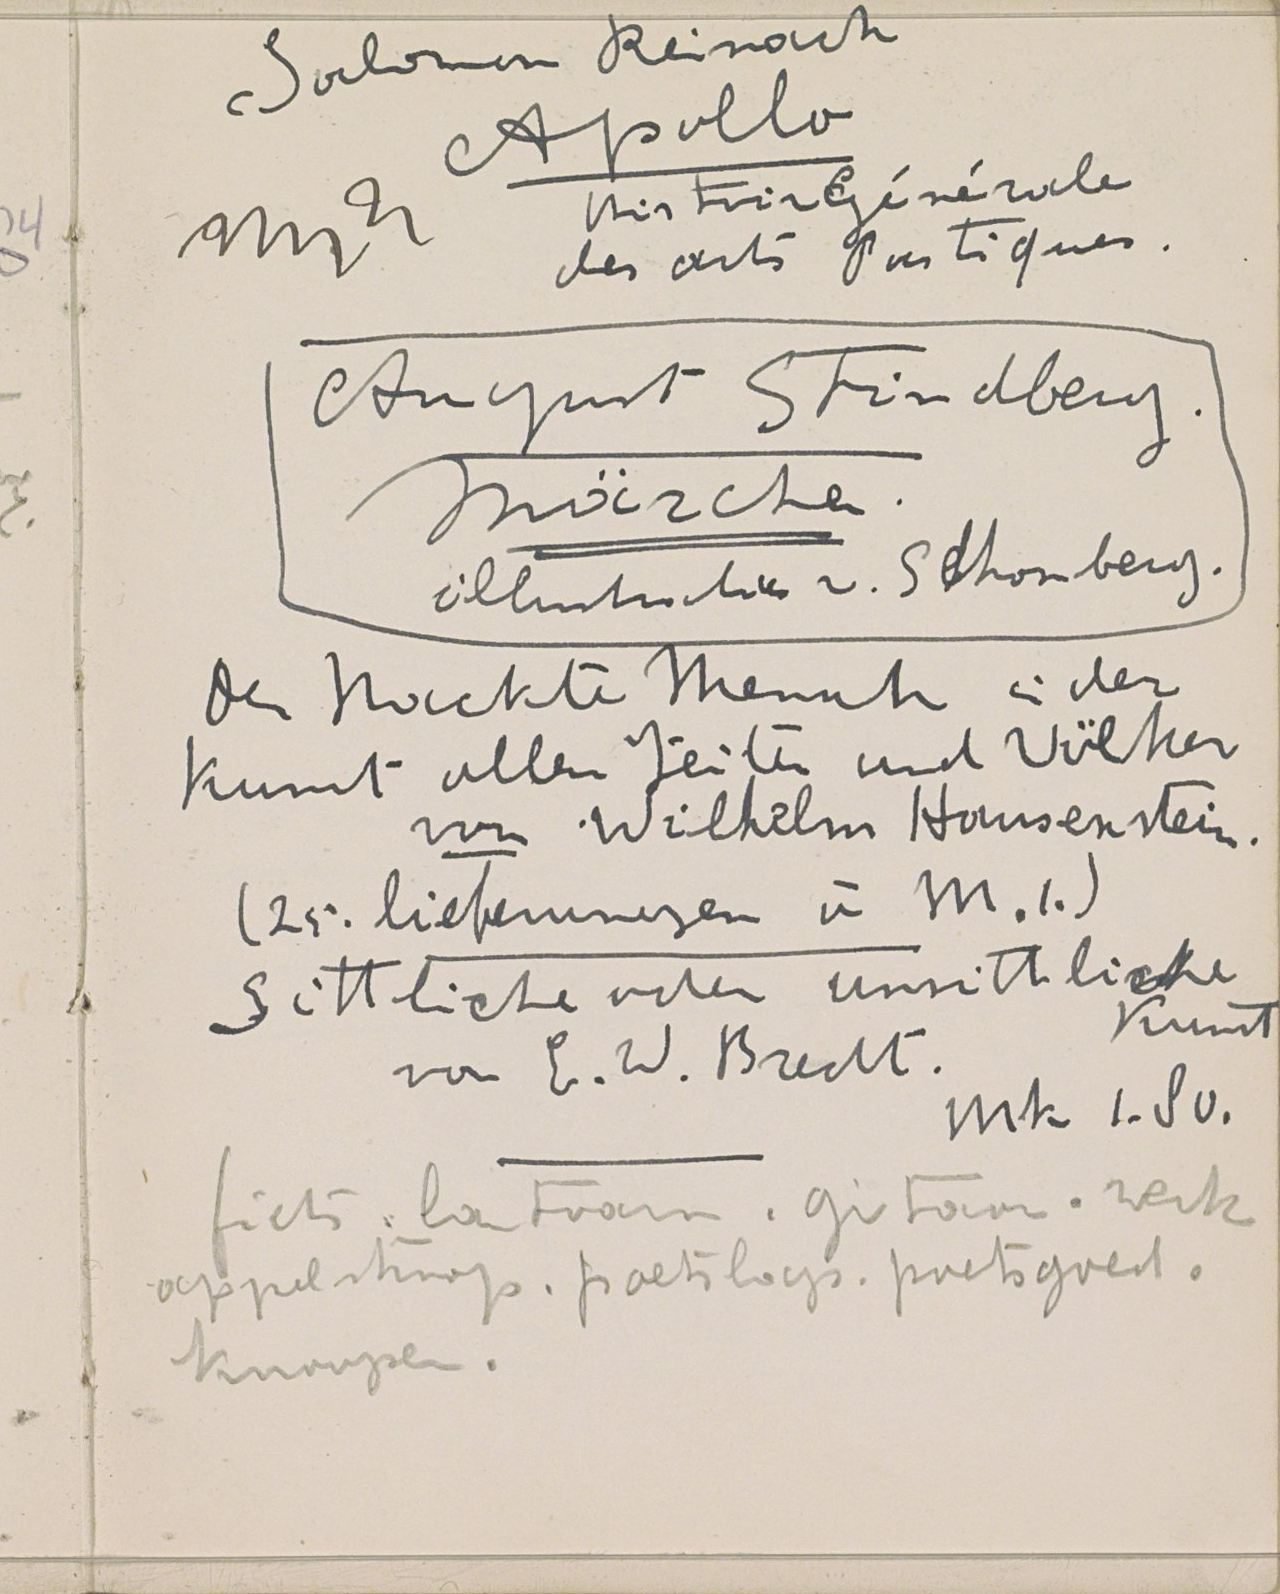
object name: sketchbook leaf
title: Notities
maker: reijer stolk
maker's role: draughtsman, print maker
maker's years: 1896-1945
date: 1916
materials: ink, paper, pencil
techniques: pen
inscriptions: annotation: ‘Solomon Reinout/ Apollo/ [...]’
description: Blad 70 recto uit een schetsboek met 72 bladen.